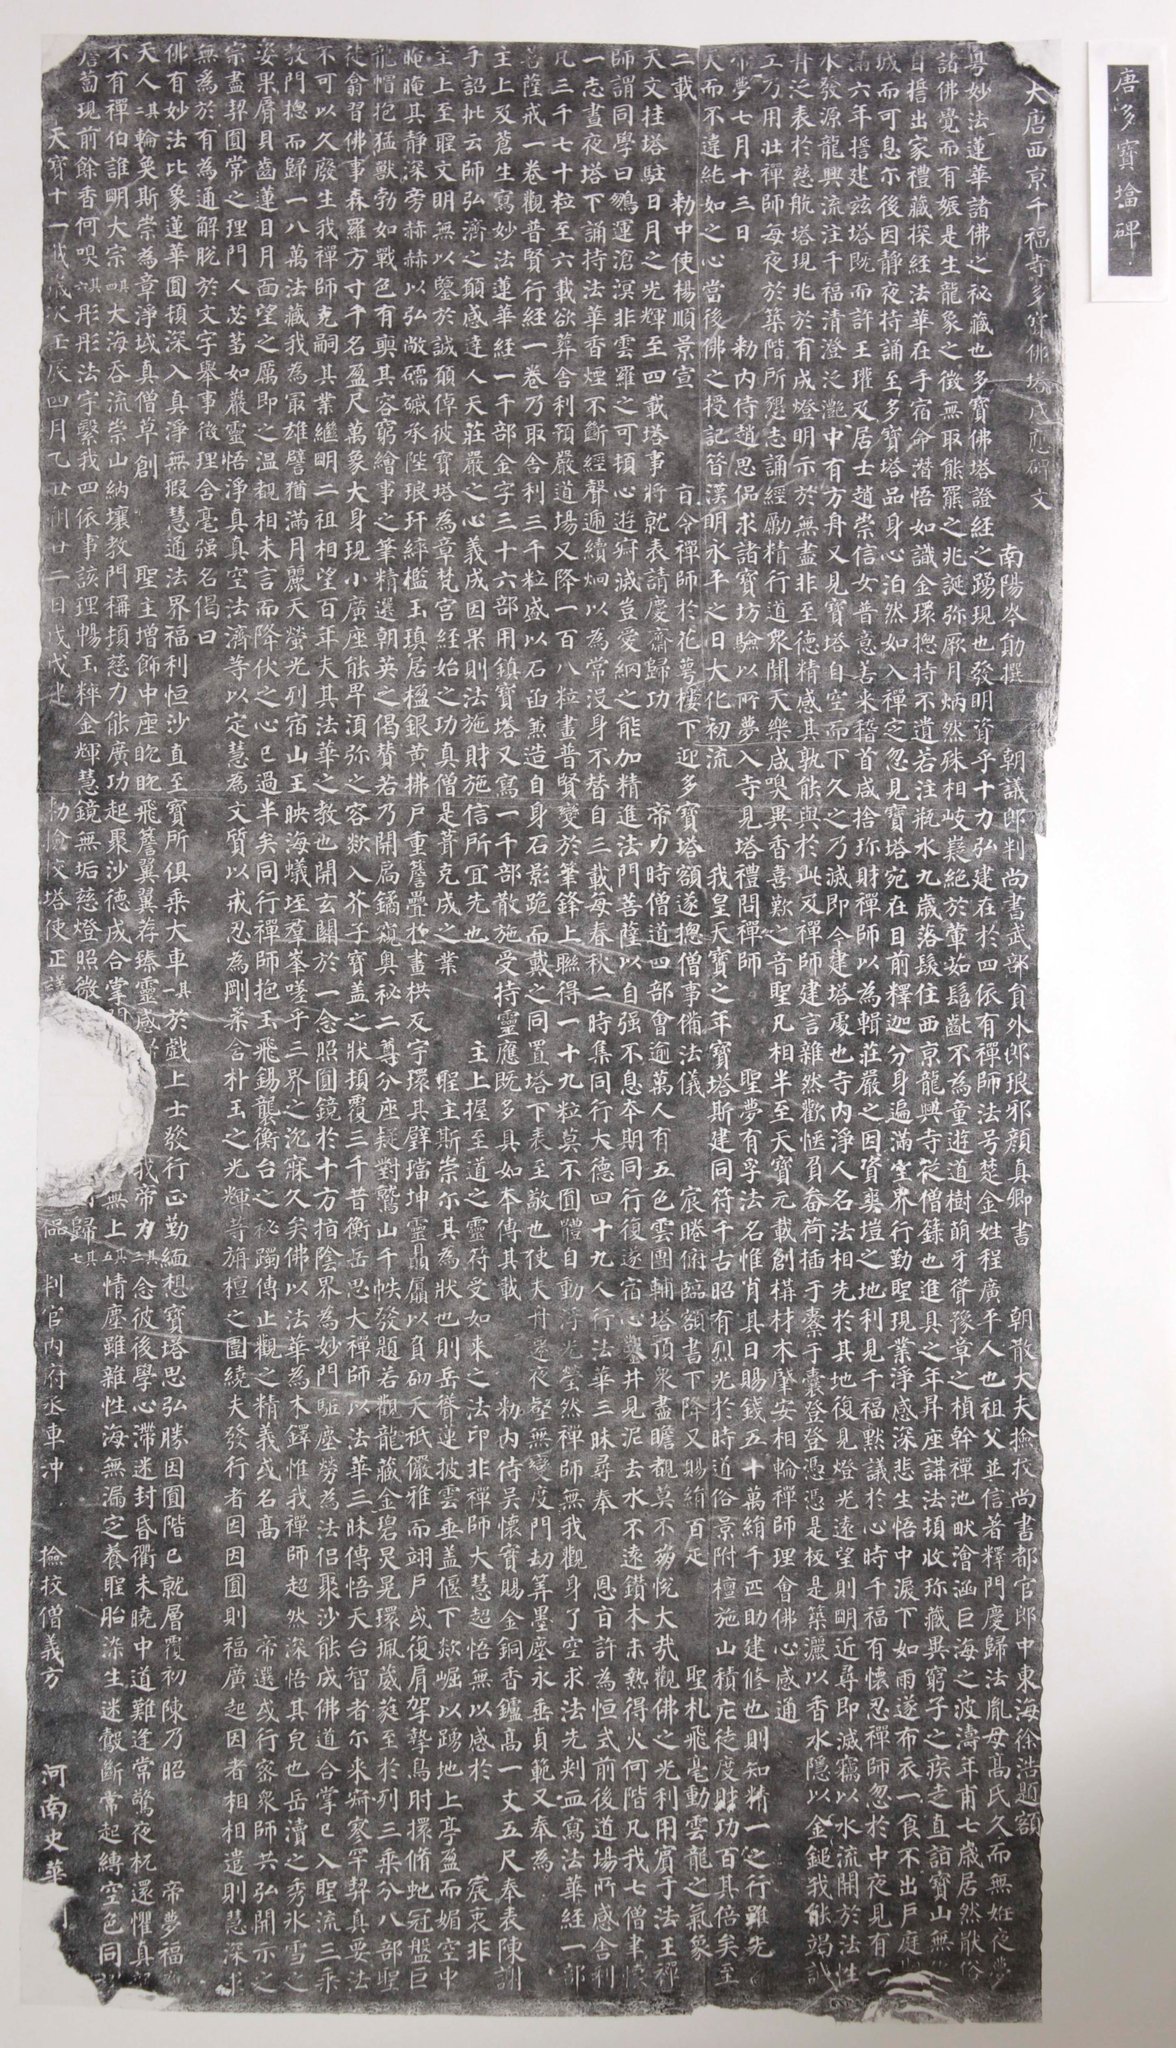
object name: rubbing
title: Stele for the Duobao Pagoda of the Qianfusi, in Shensi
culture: chinese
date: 1901-2000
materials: ink, paper